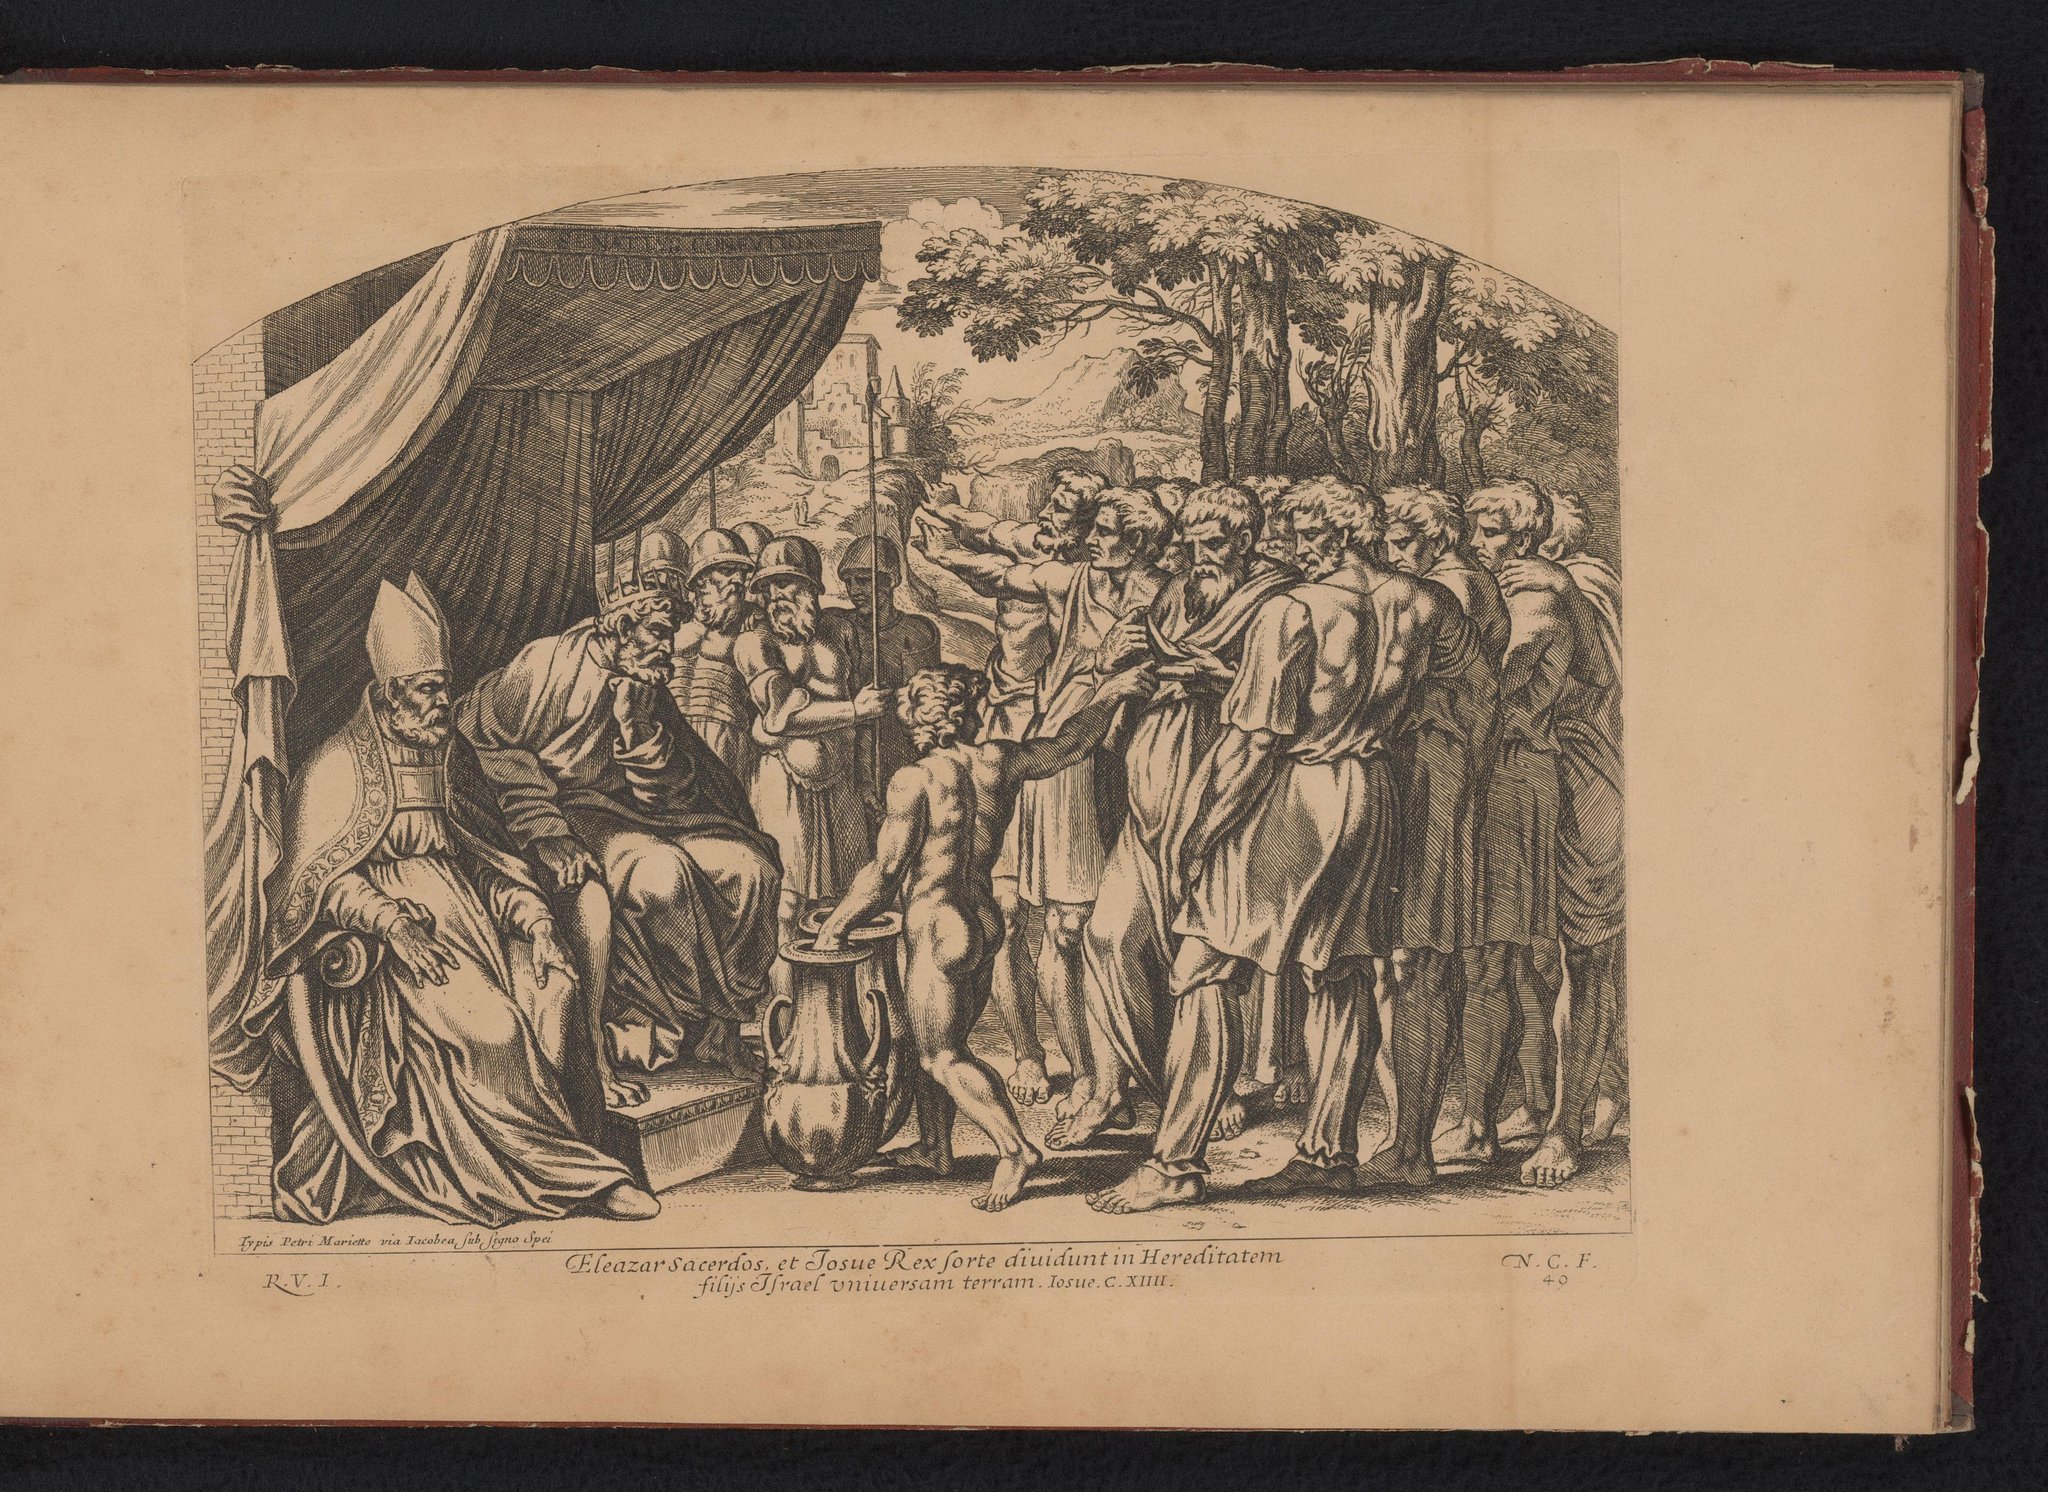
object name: album leaf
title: Jozua beveelt de zon en de maan stil te staan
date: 1649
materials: paper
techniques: etching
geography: paris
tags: joshua orders the sun and the moon to stand still over gibeon and aijalon until the amorites who had besieged the city of gibeon are routed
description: Deze prent maakt deel uit van een album.